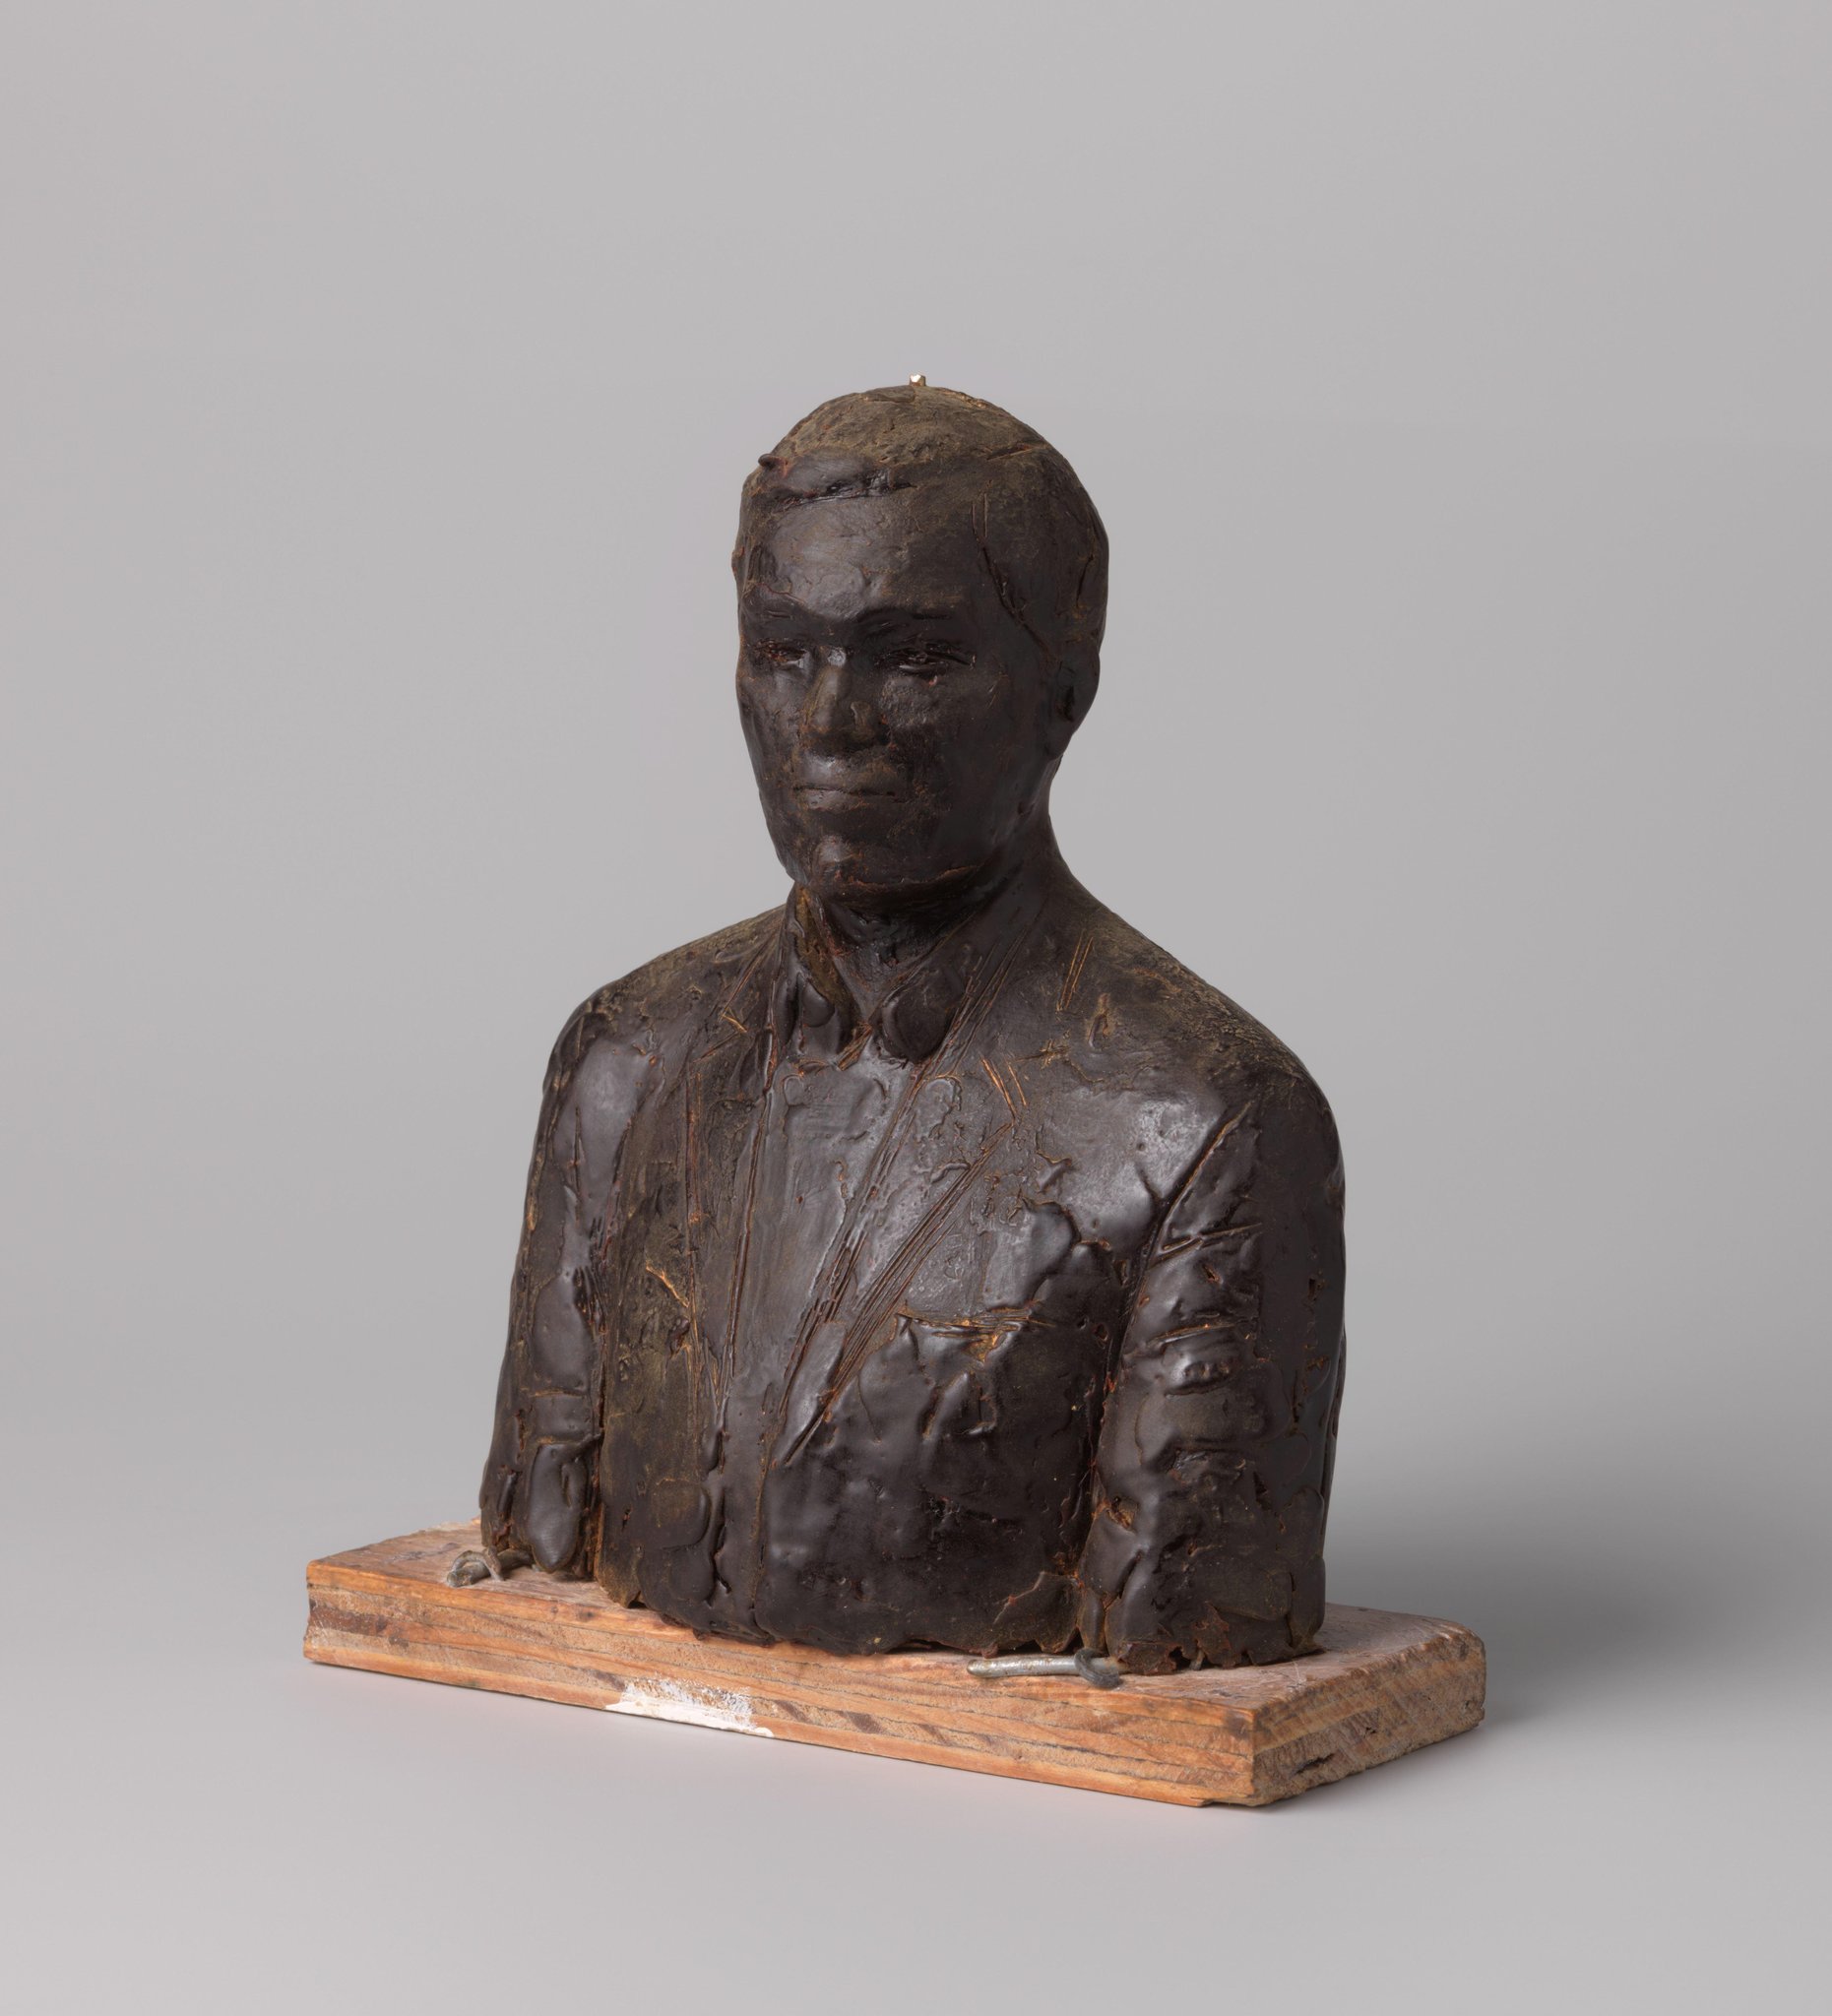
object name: bust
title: Schets van was voor buste Ronald de Leeuw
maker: tony van de vorst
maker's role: sculptor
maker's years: 1946-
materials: wax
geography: vlierden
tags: ronald de leeuw